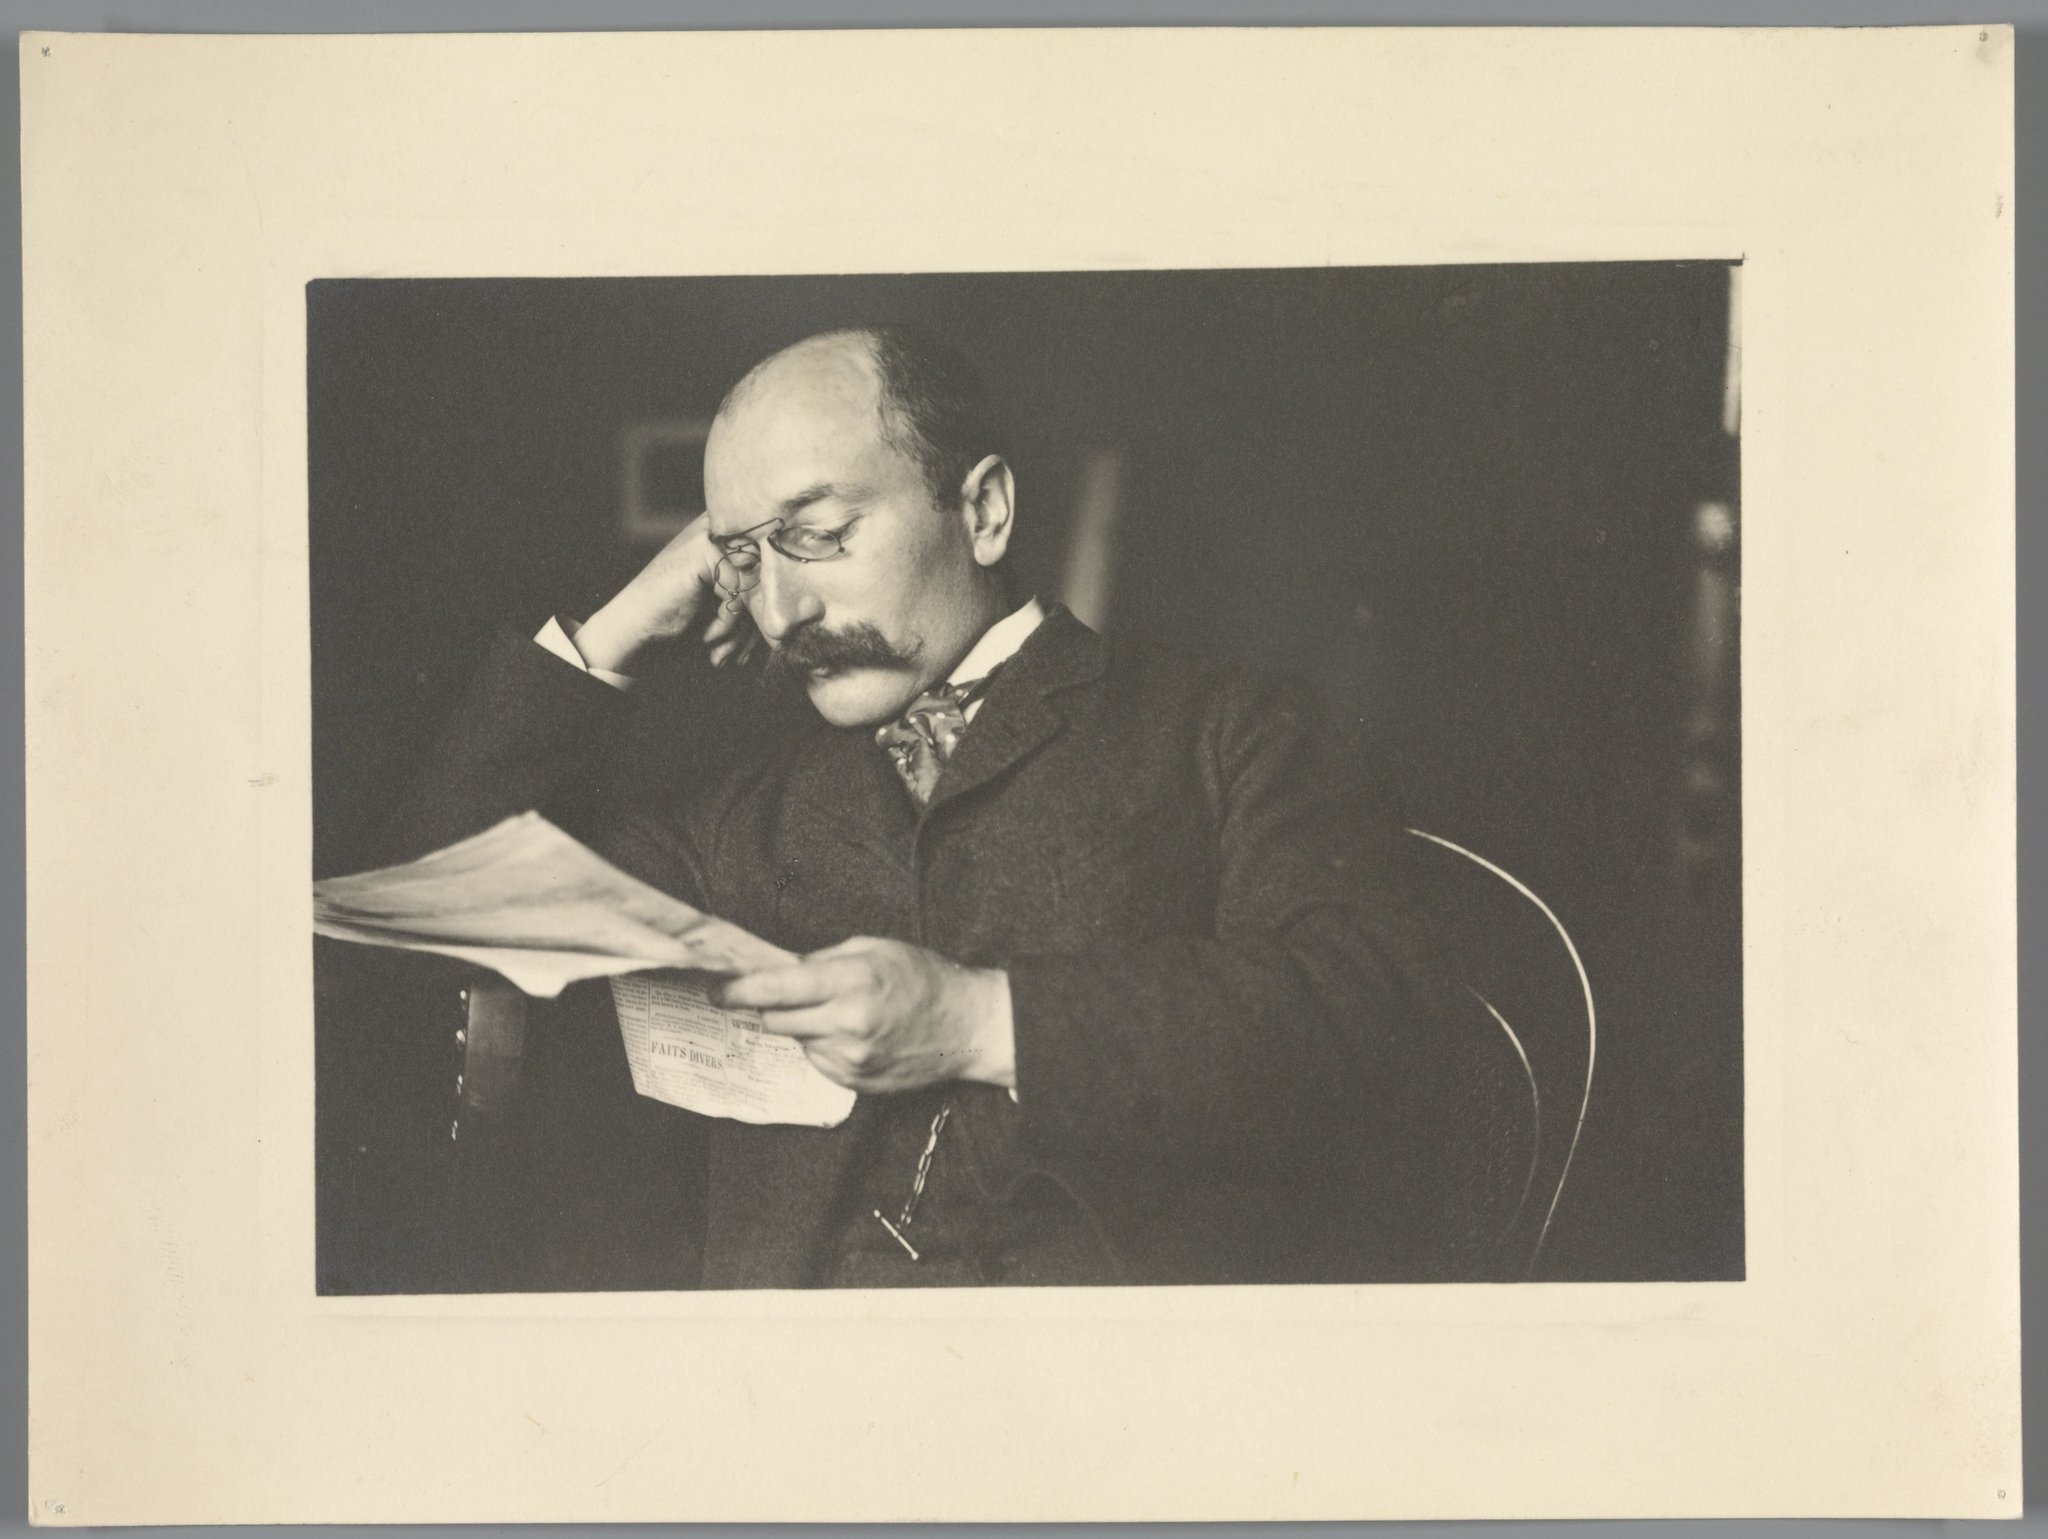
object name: photograph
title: Reproductie naar een foto van Willem Witsen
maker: Anonymous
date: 1860-1915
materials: paper, photographic support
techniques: gelatin silver print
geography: netherlands